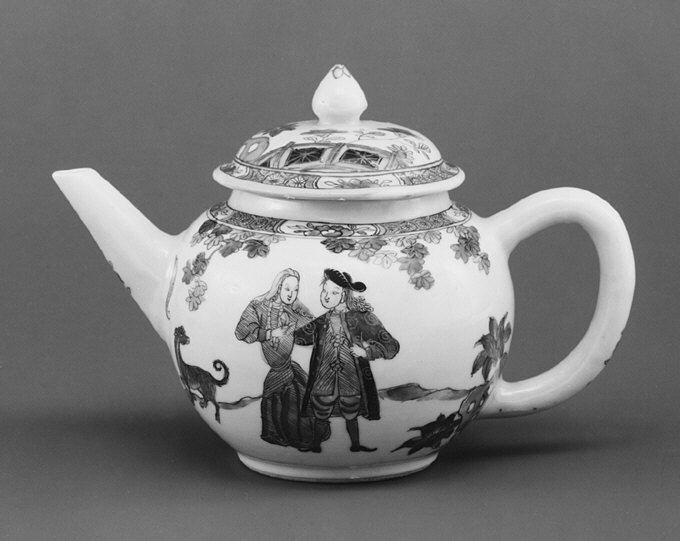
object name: teapot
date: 1715-1720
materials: hard paste porcelain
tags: animals,men,women